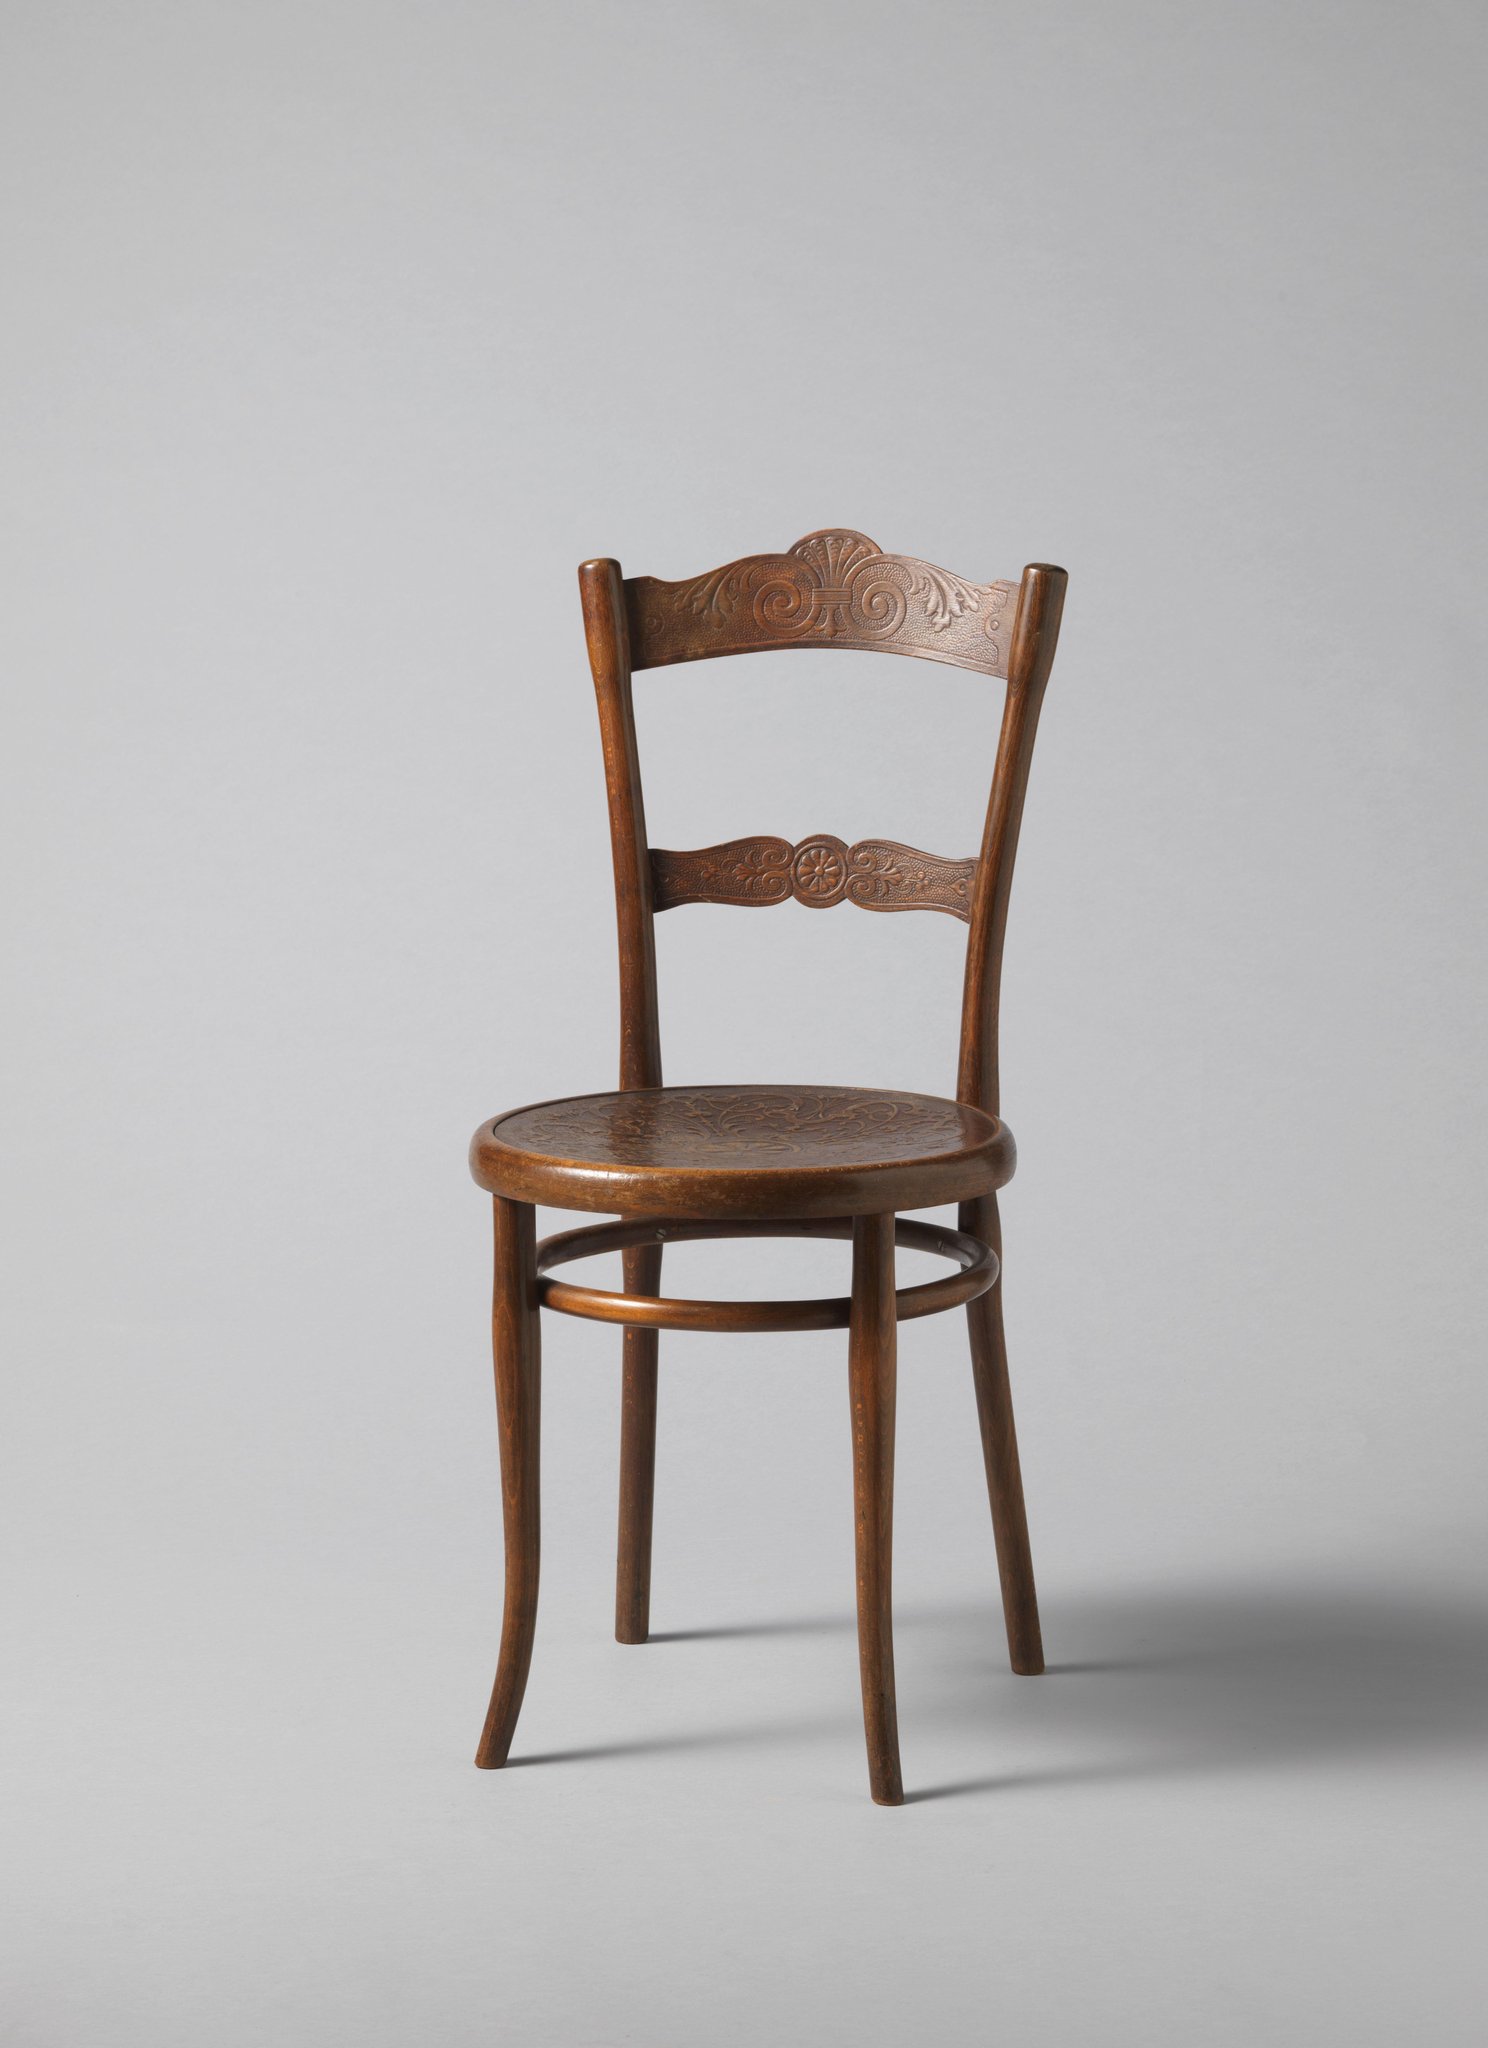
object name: seating furniture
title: Meubilair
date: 1900-1987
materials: wood, iron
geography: germany